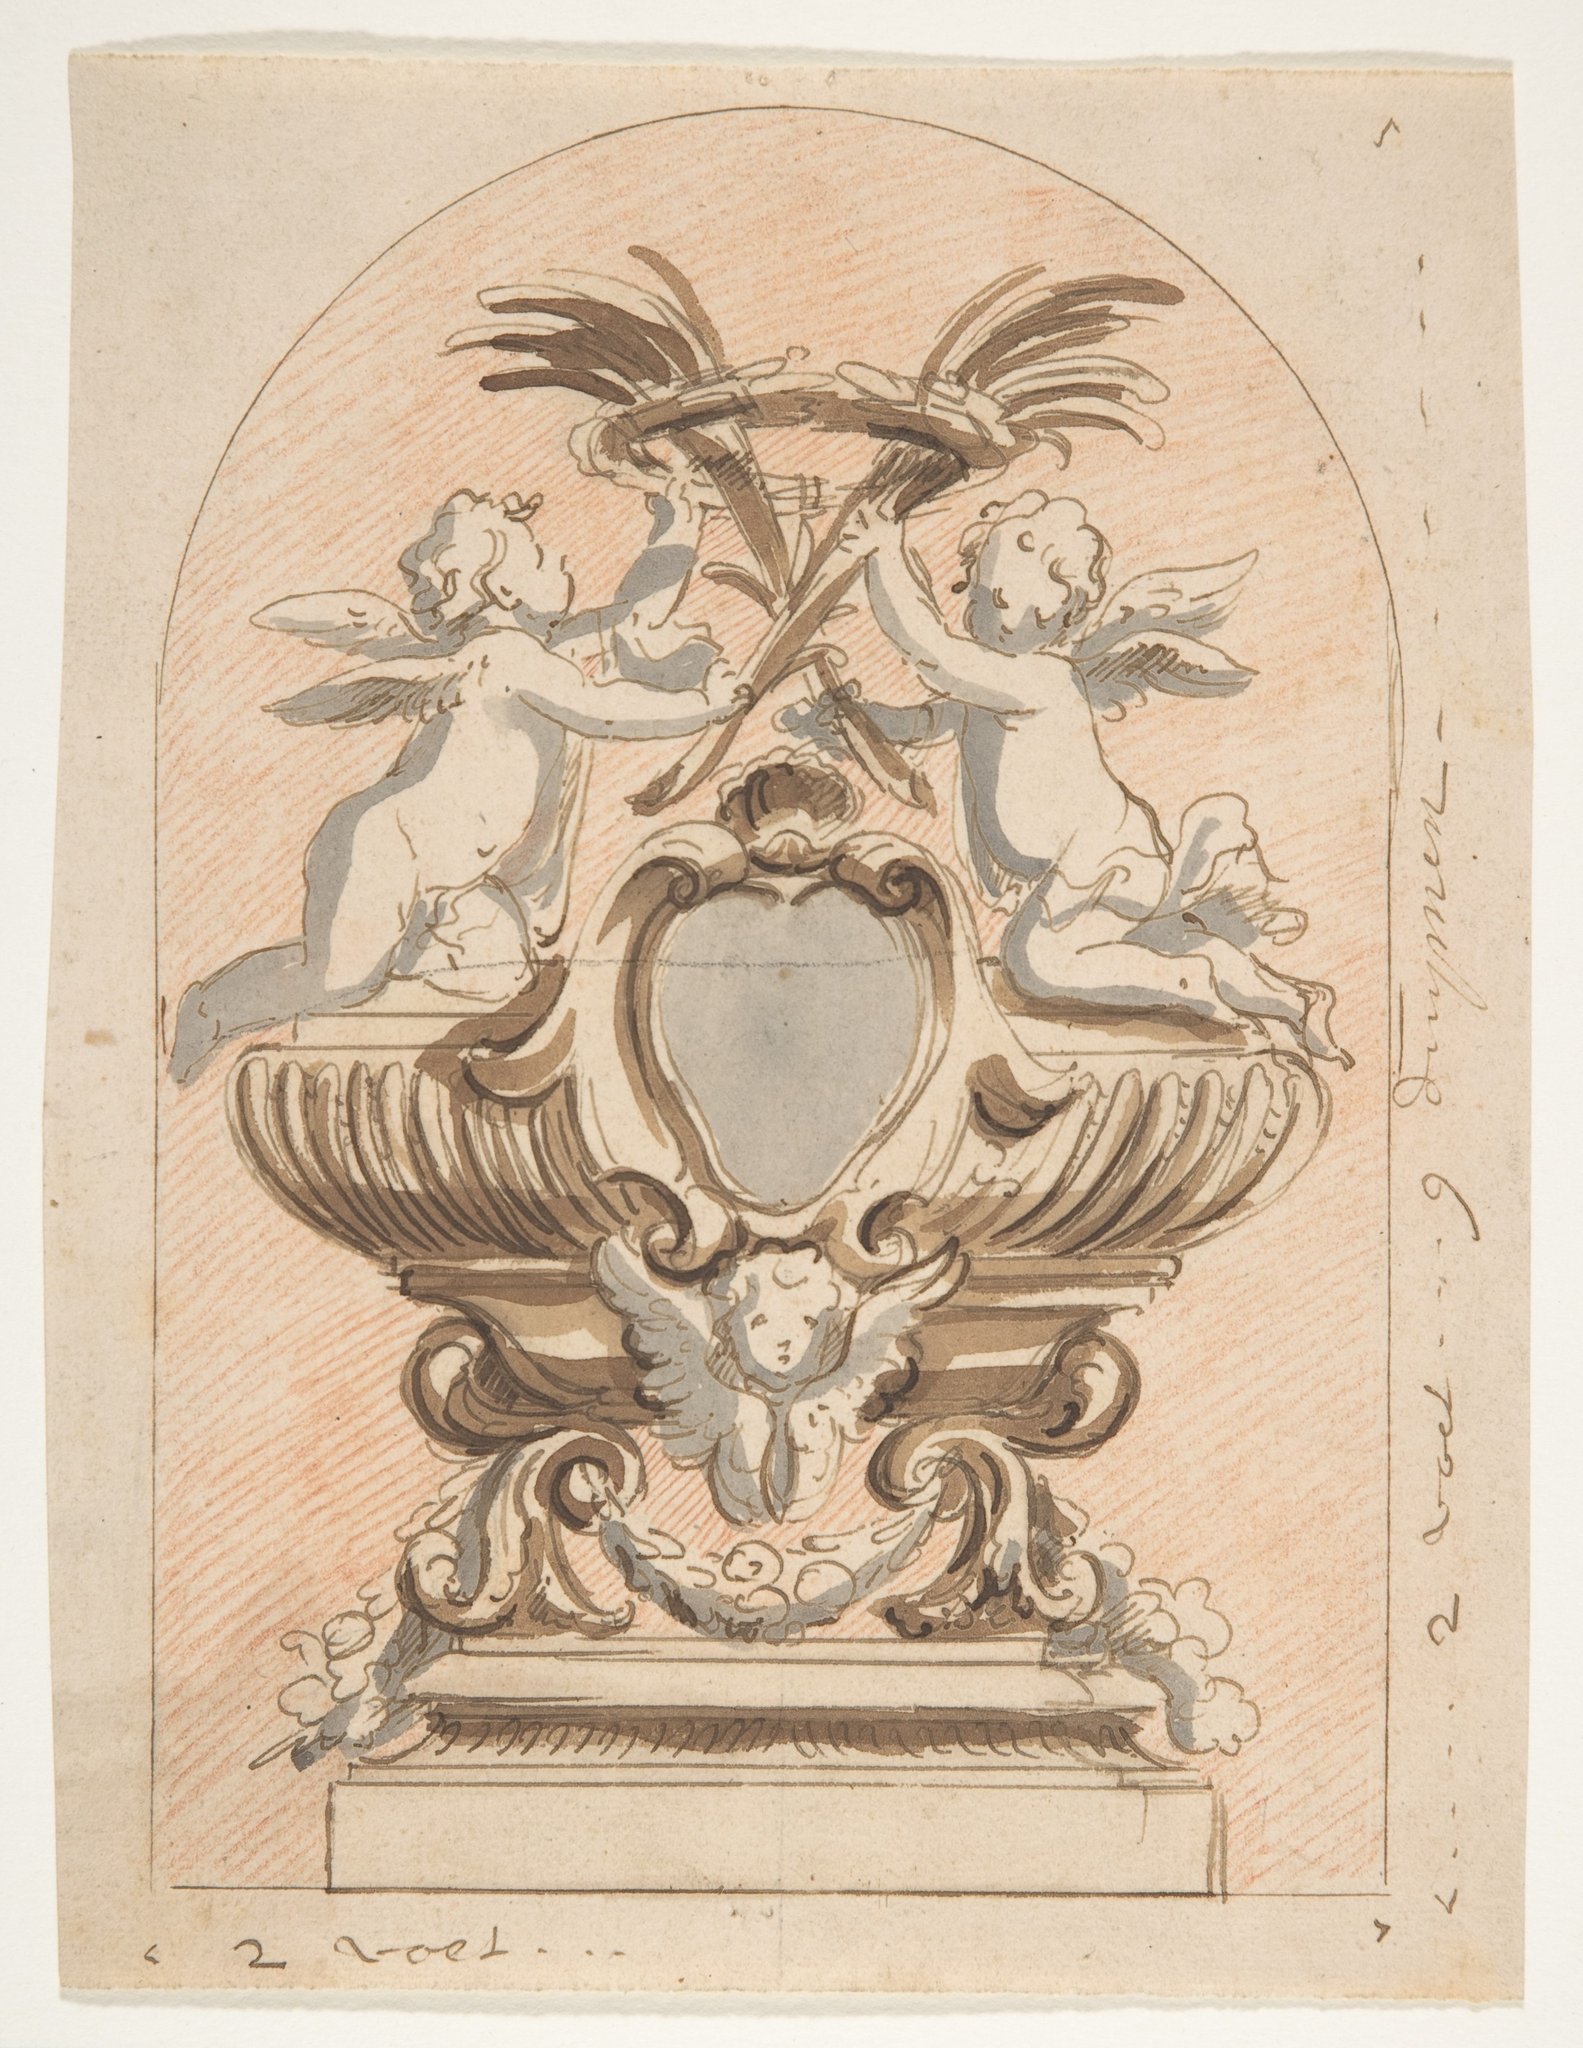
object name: drawing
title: Design for a reliquary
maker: pieter verbruggen the younger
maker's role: artist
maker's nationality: flemish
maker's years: 1648-1691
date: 1667-1733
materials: chalk, ink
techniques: pen, wash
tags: reliquaries